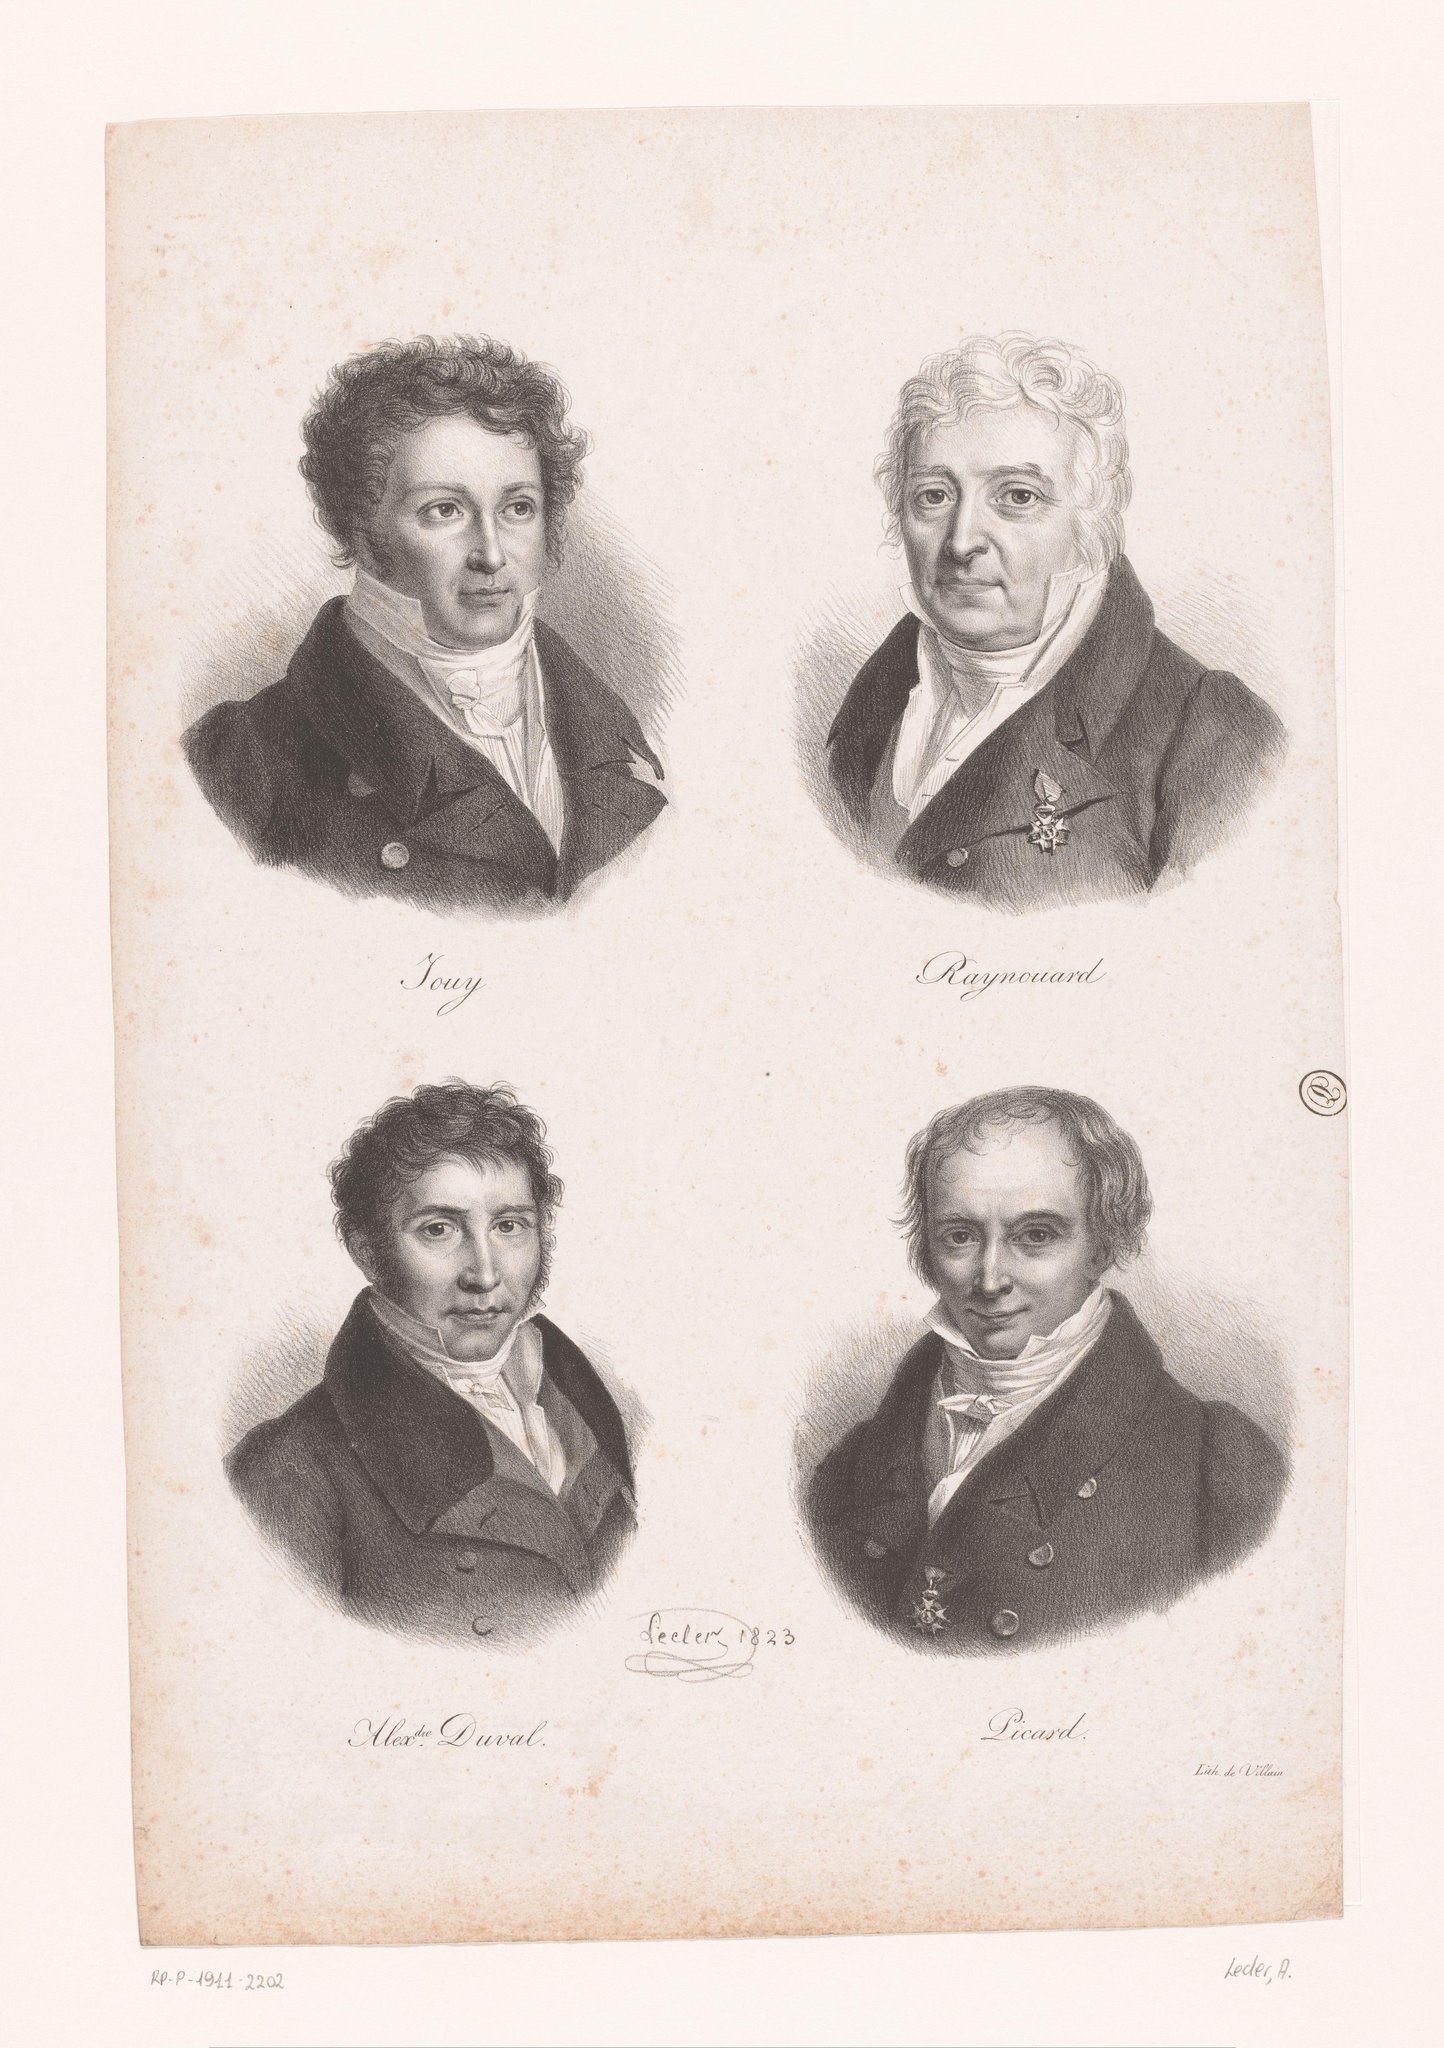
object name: print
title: Portretten van vier Franse schrijvers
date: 1823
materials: paper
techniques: lithograph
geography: paris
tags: paris, historical persons, portrait of a writer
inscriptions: collector's mark: Lugt 2228a, stamp: Lugt 4724